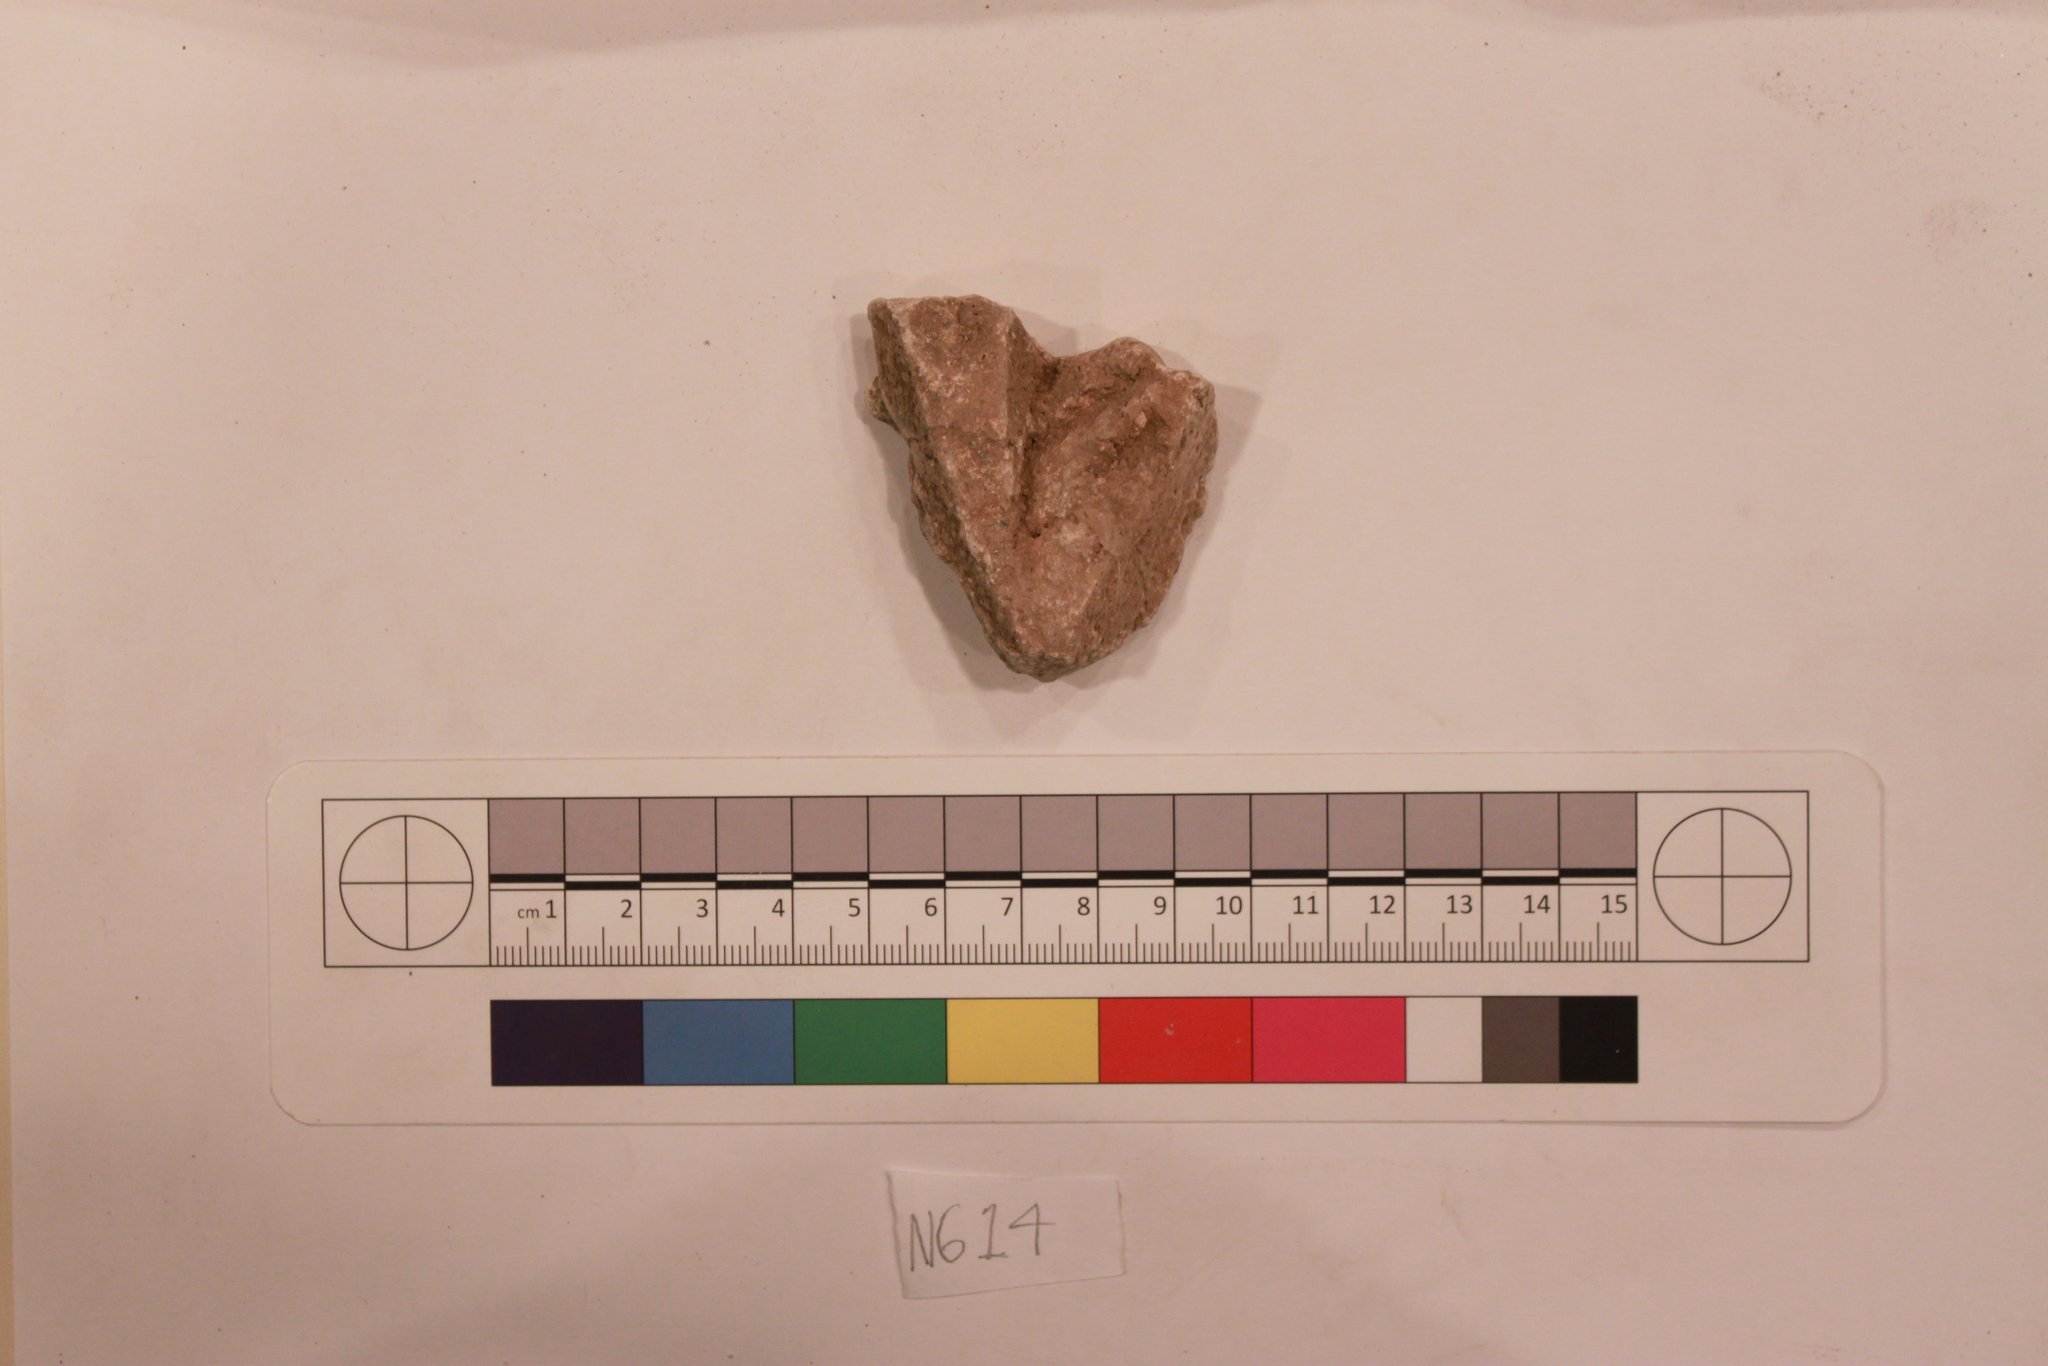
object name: fragment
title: Stucco Fragment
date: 701-1200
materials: plaster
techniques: carving, painting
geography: iran